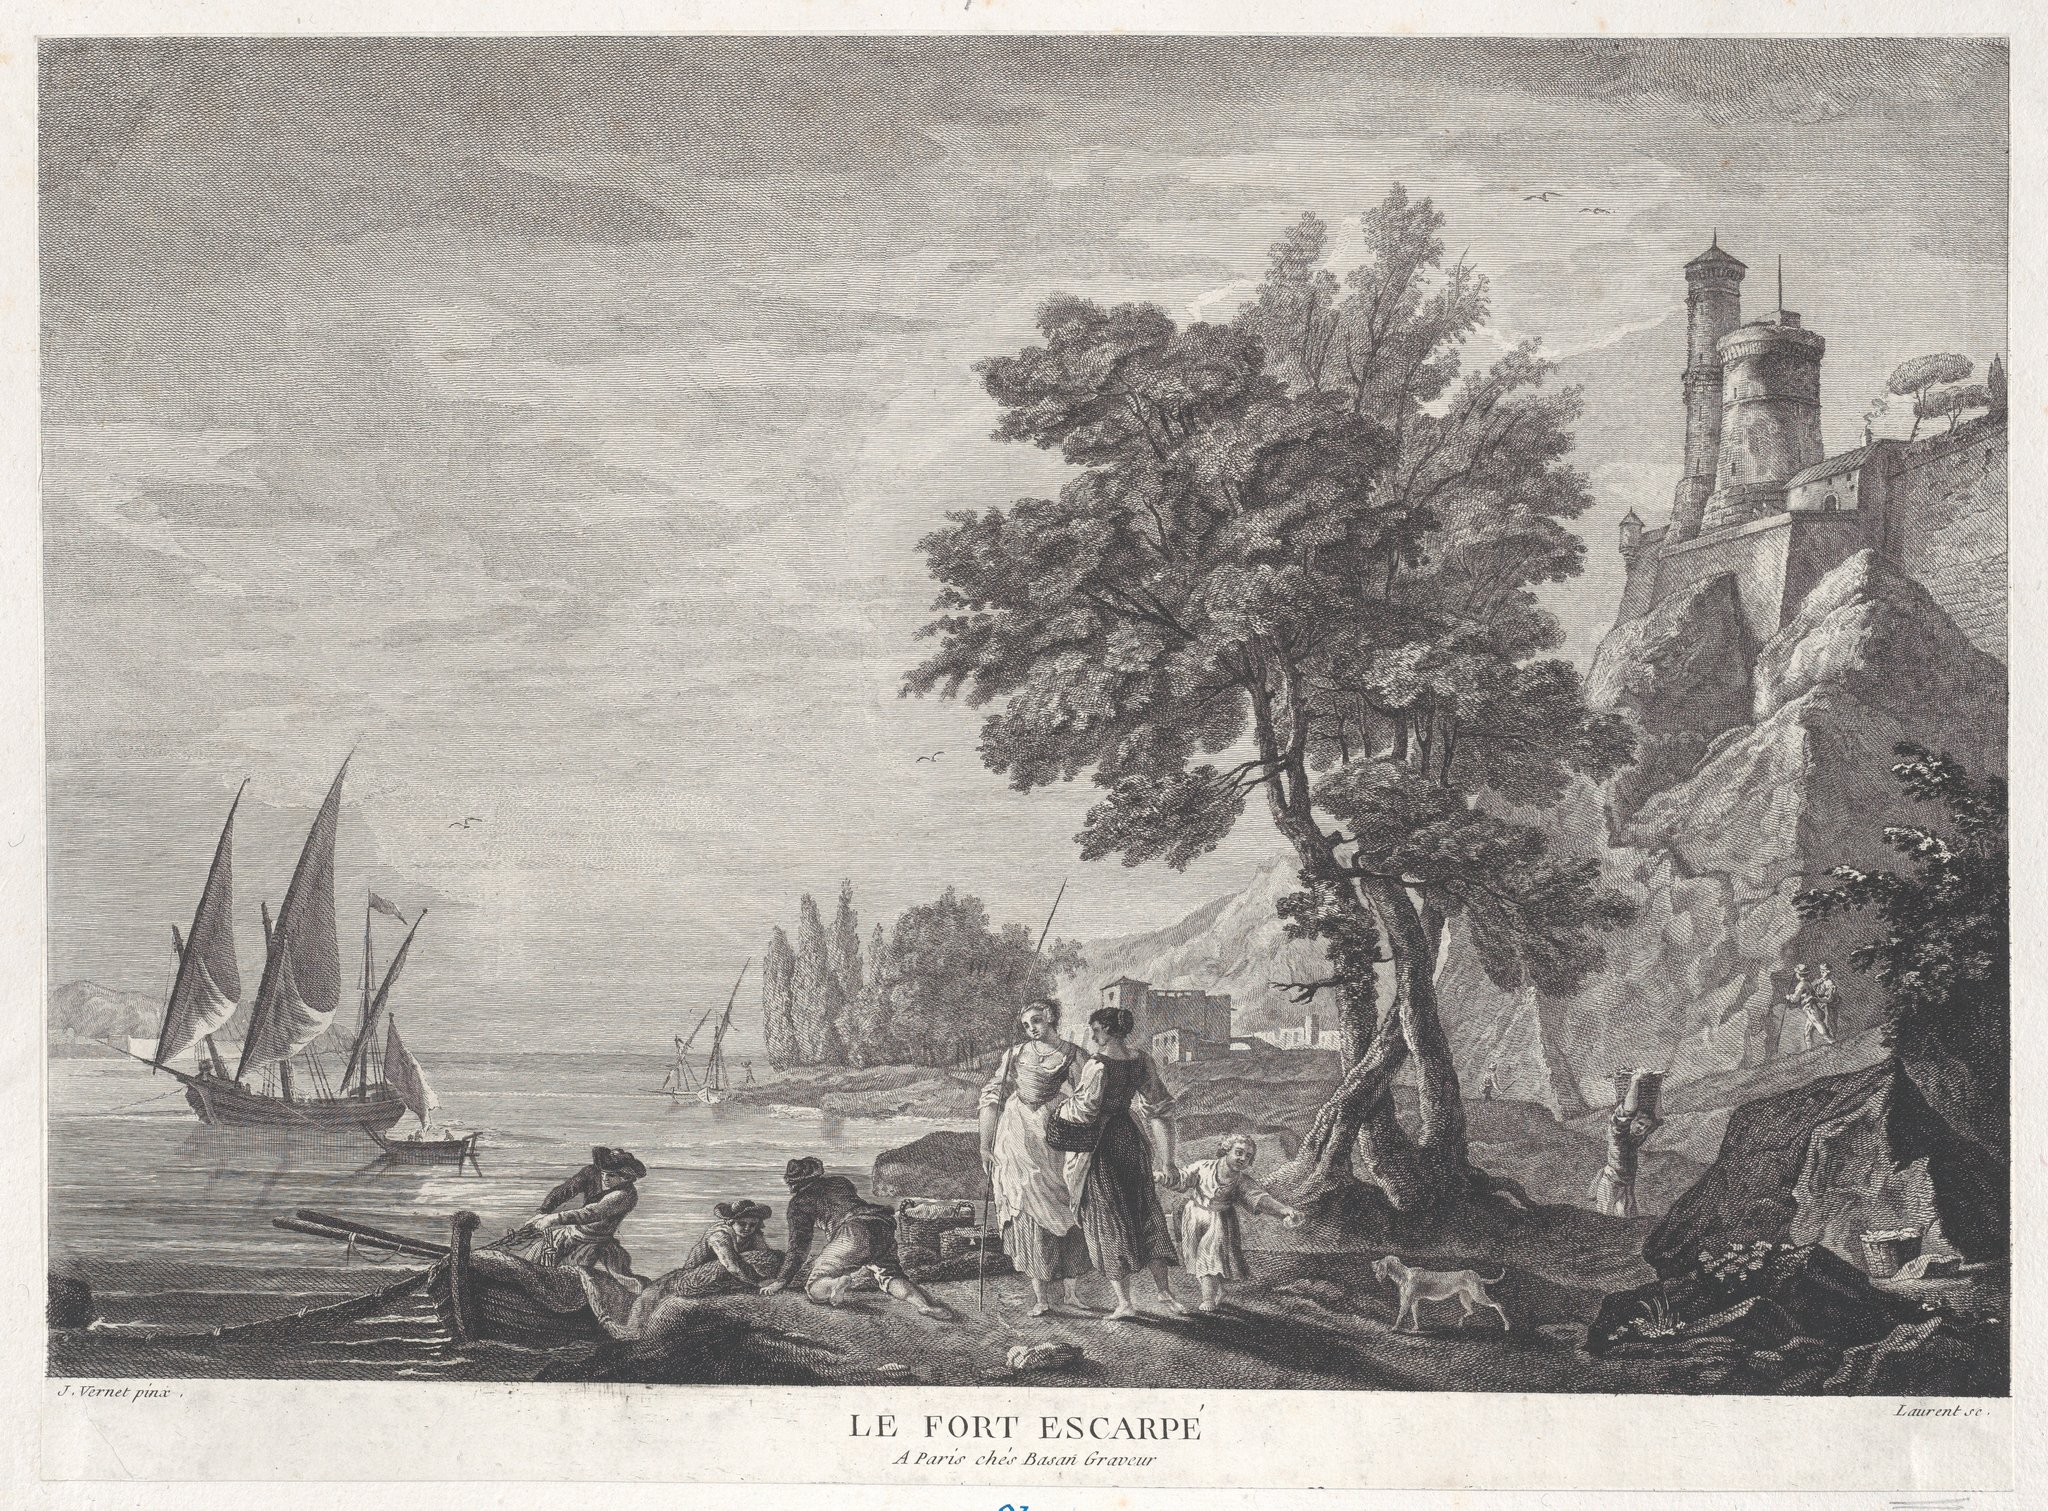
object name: print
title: The Steep Fort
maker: joseph vernet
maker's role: artist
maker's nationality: french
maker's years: 1714-1789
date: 1750-1800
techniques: engraving